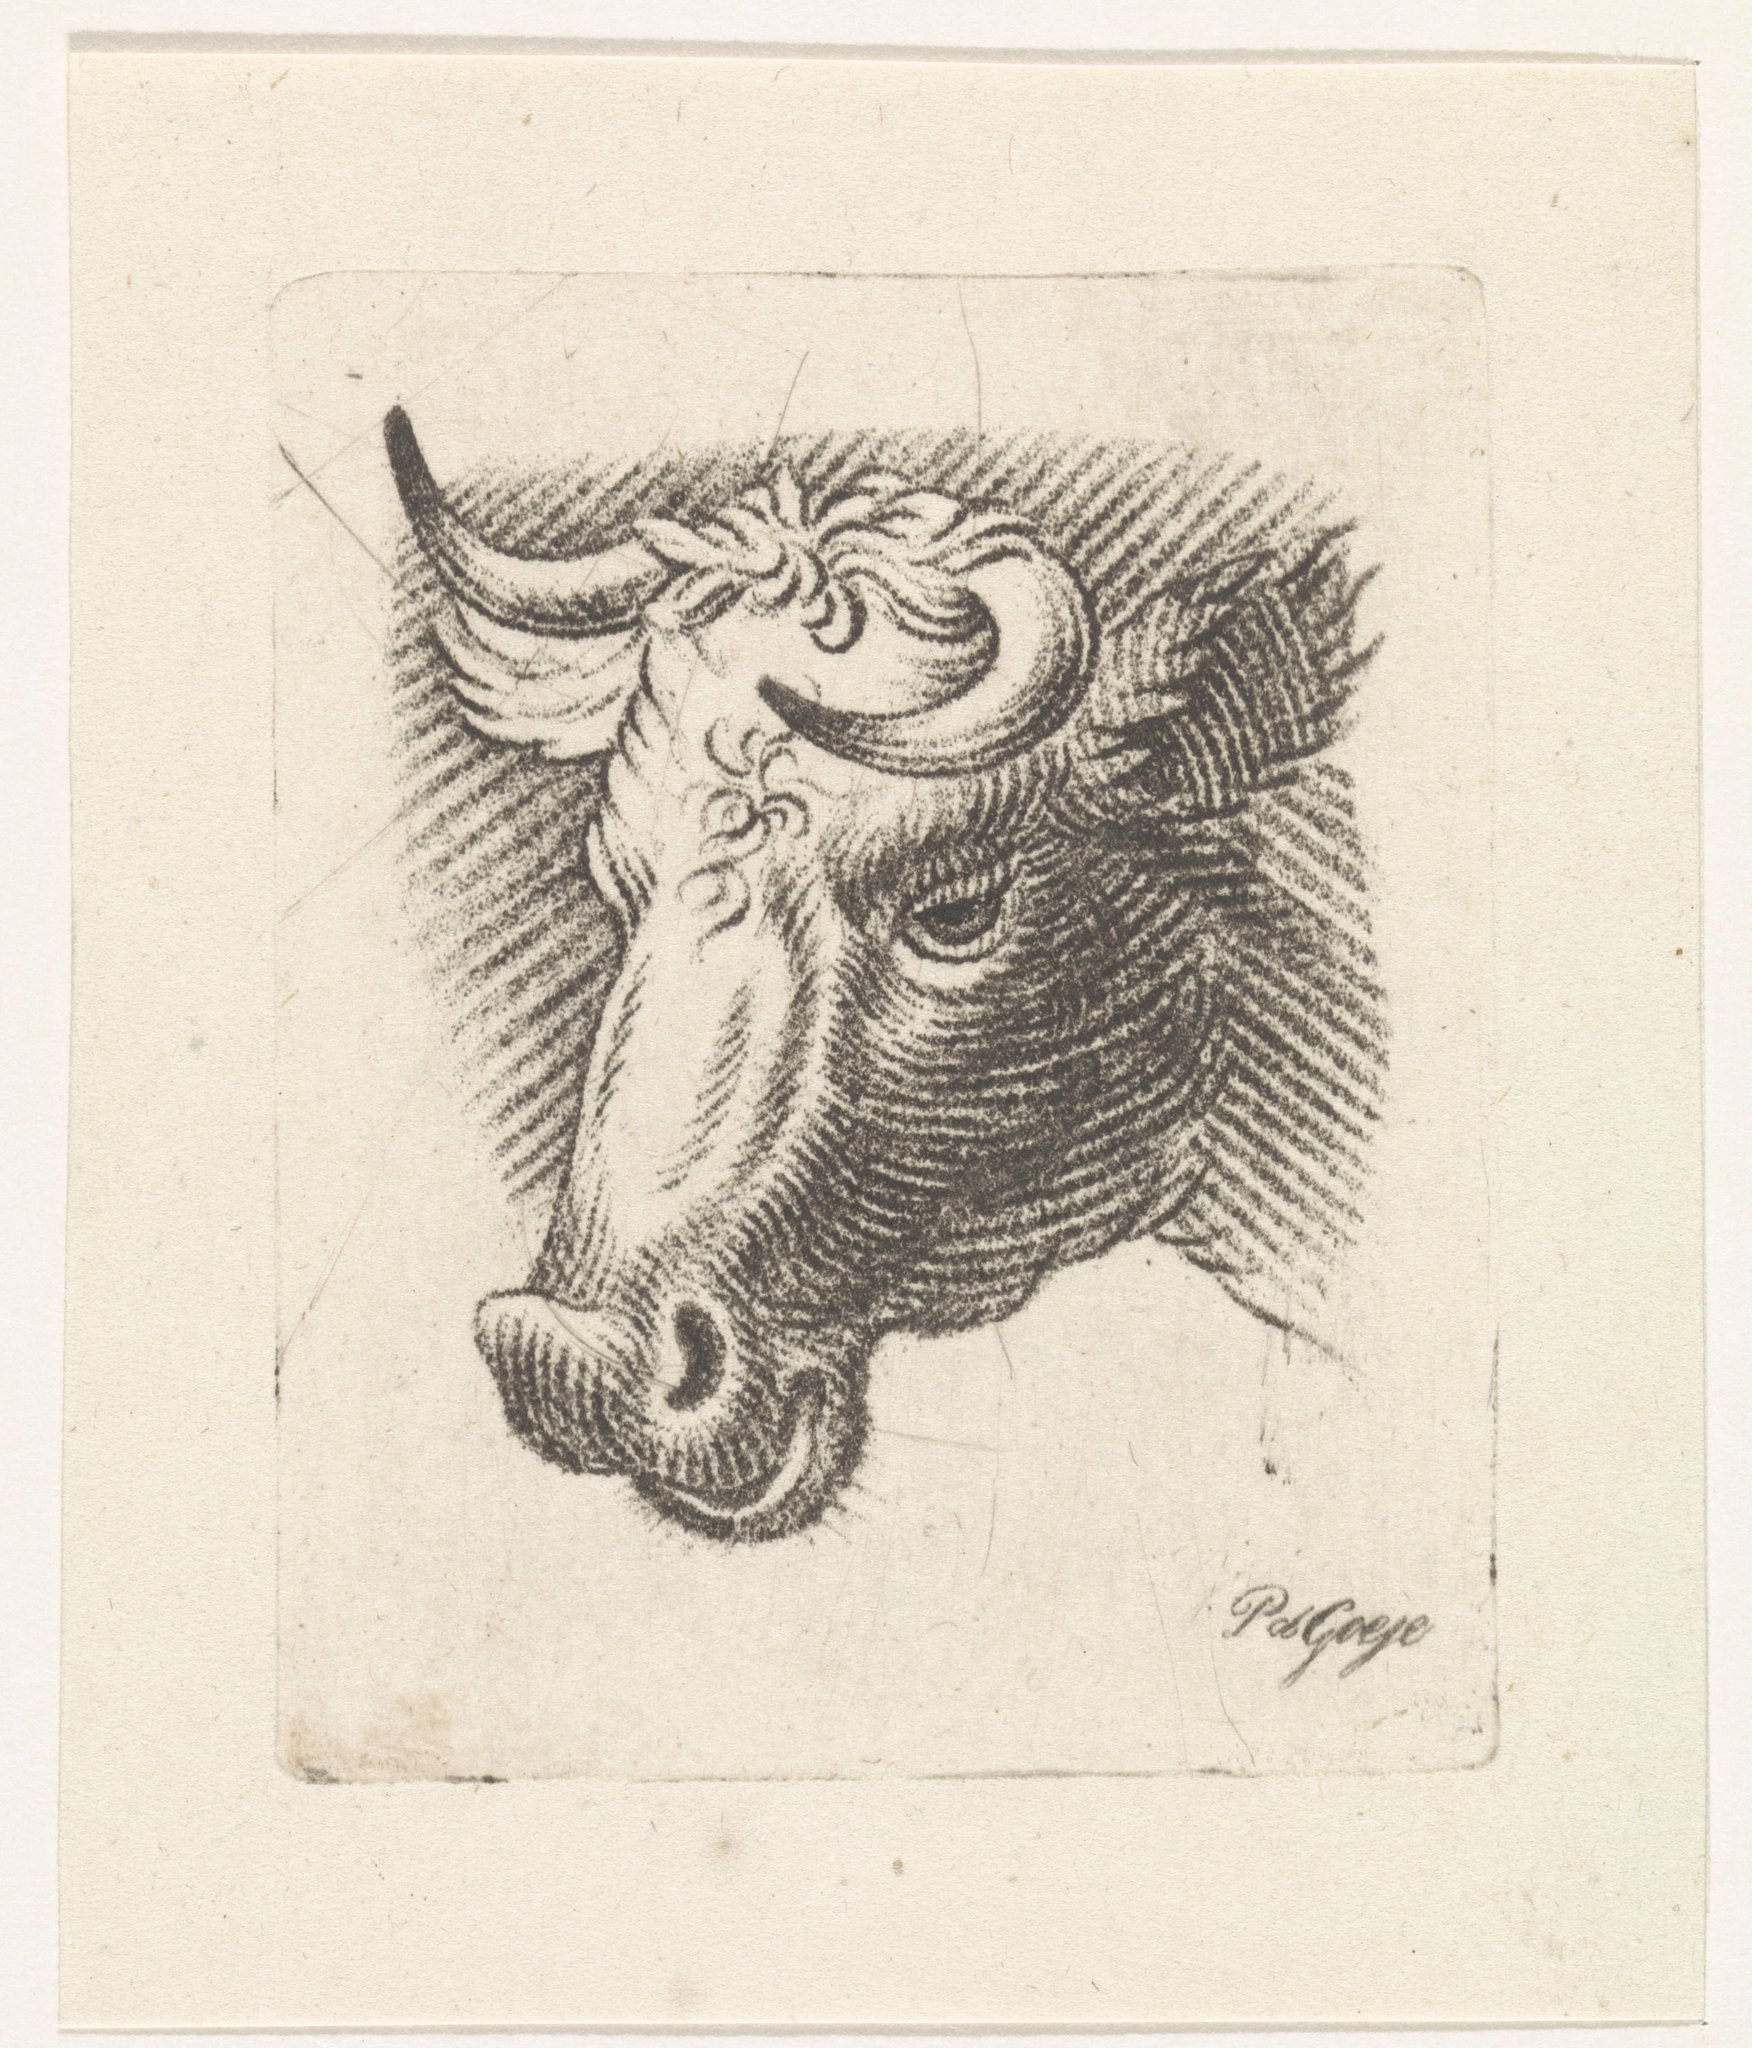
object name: print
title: Kop van een stier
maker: pieter de goeje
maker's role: draughtsman, print maker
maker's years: 1789-1859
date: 1789-1859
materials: paper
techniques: printmaking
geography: amsterdam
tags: bull (+ head of an animal)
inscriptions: collector's mark: Lugt 2228